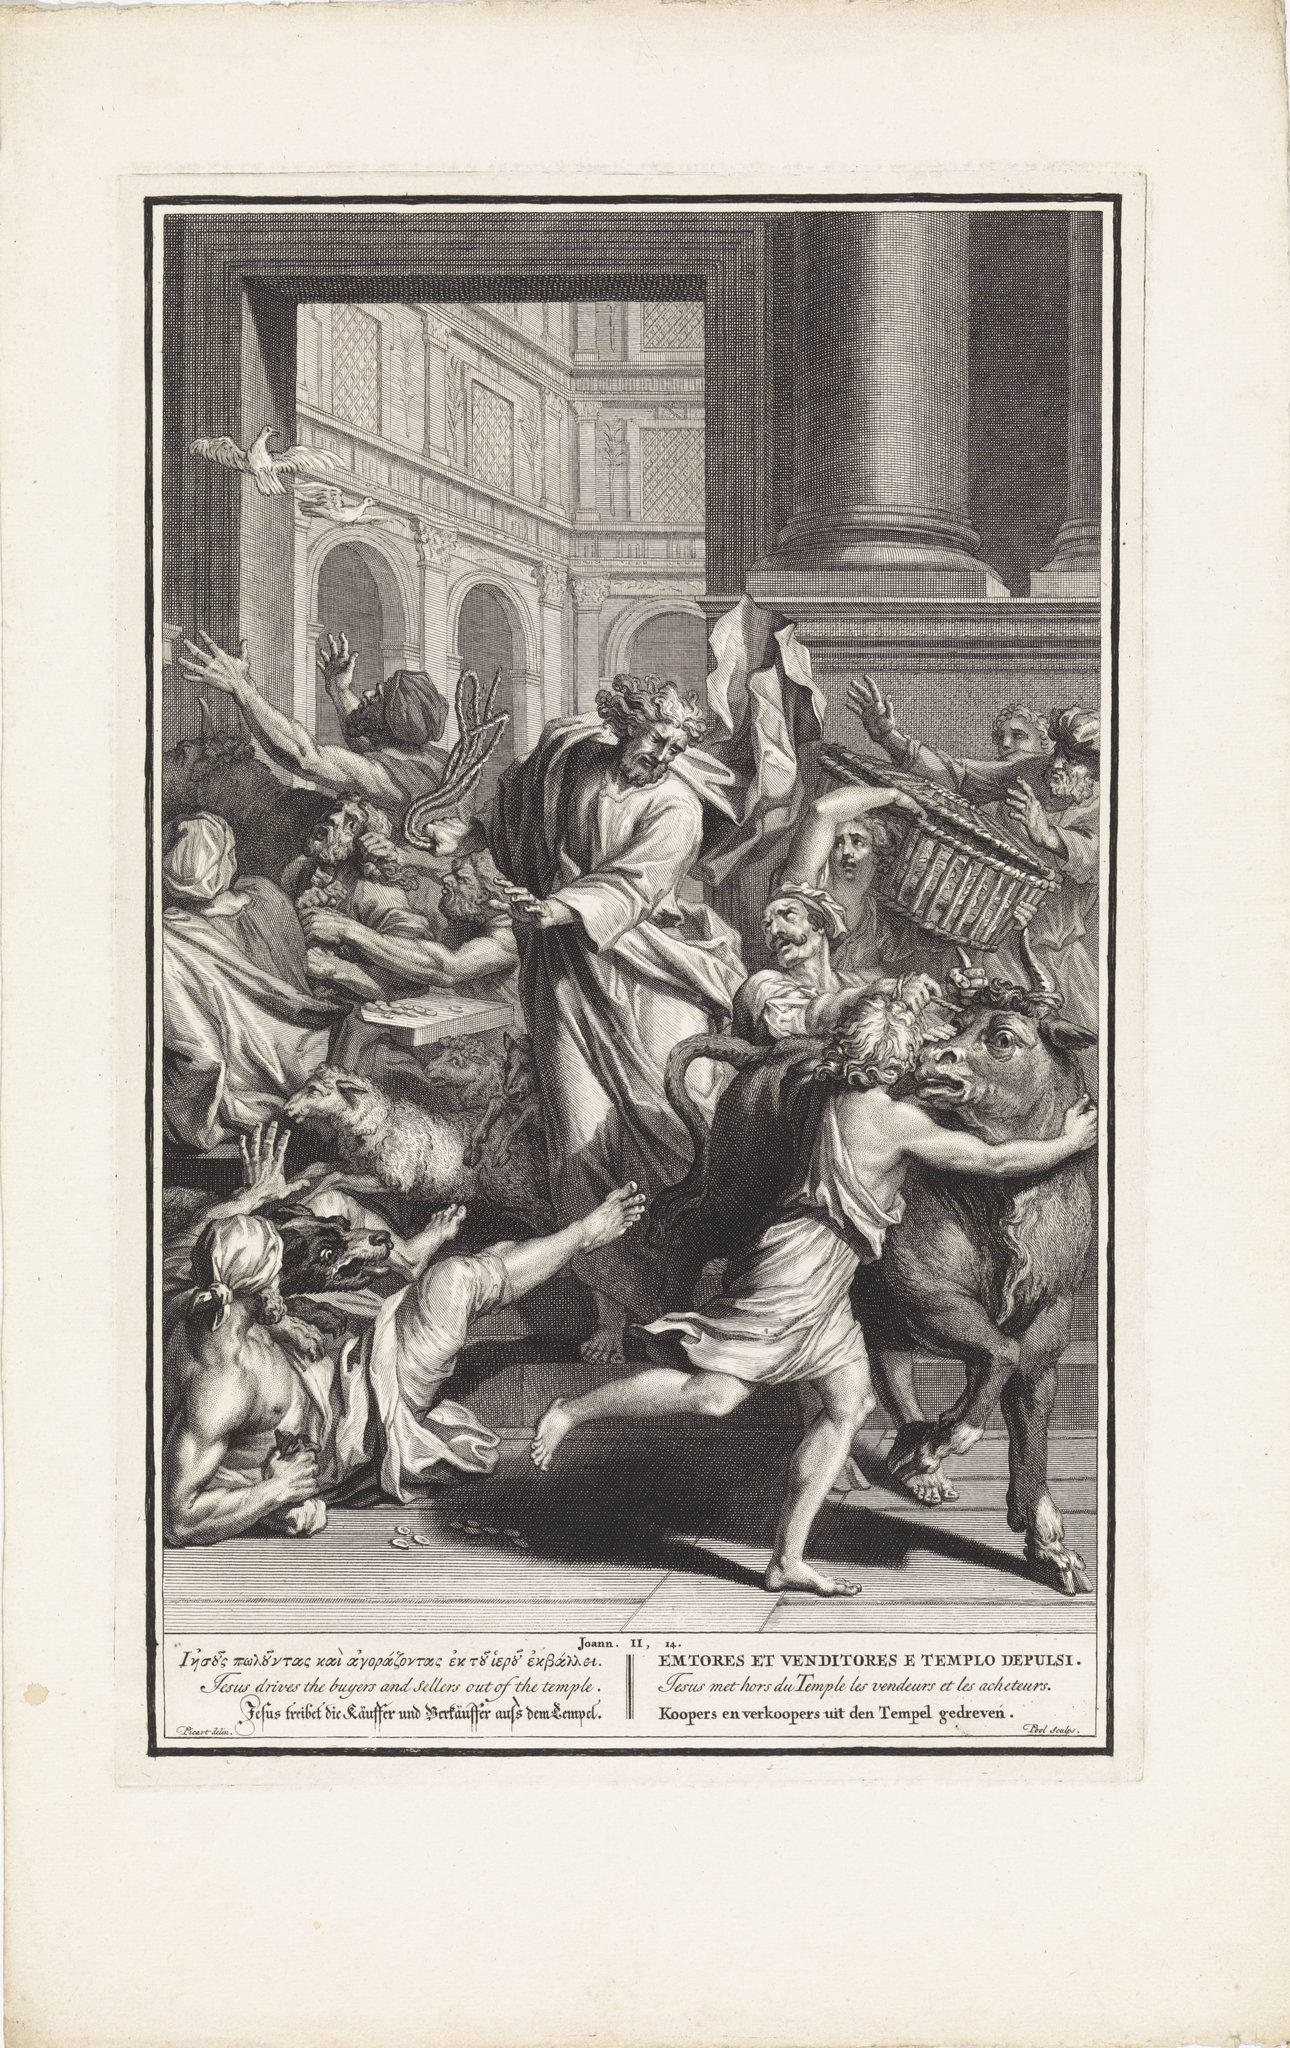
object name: book illustration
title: Verdrijving van de wisselaars uit de tempel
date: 1705-1720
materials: paper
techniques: engraving, etching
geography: amsterdam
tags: purification of the temple ('first' and 'second'): christ driving the money-changers from the temple with a whip (matthew 21:12-13; mark 11:15-17; luke 19:45-46; john 12:12-19)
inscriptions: collector's mark: Lugt 2228, inscription: ‘Utrechts Fundatie huijs’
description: Christus staat in het midden van de tempel en zwaait met zijn zweep van koorden. De handelaren proberen de slagen af te weren en naar buiten te vluchten. Schapen, runderen en duiven vluchten weg. De geldwisselaars graaien naar hun munten. Illustratie van de bijbeltekst Joh. 2:14. Onder de voorstelling de titel in het Hebreeuws, Engels, Duits, Latijn, Frans en Nederlands.